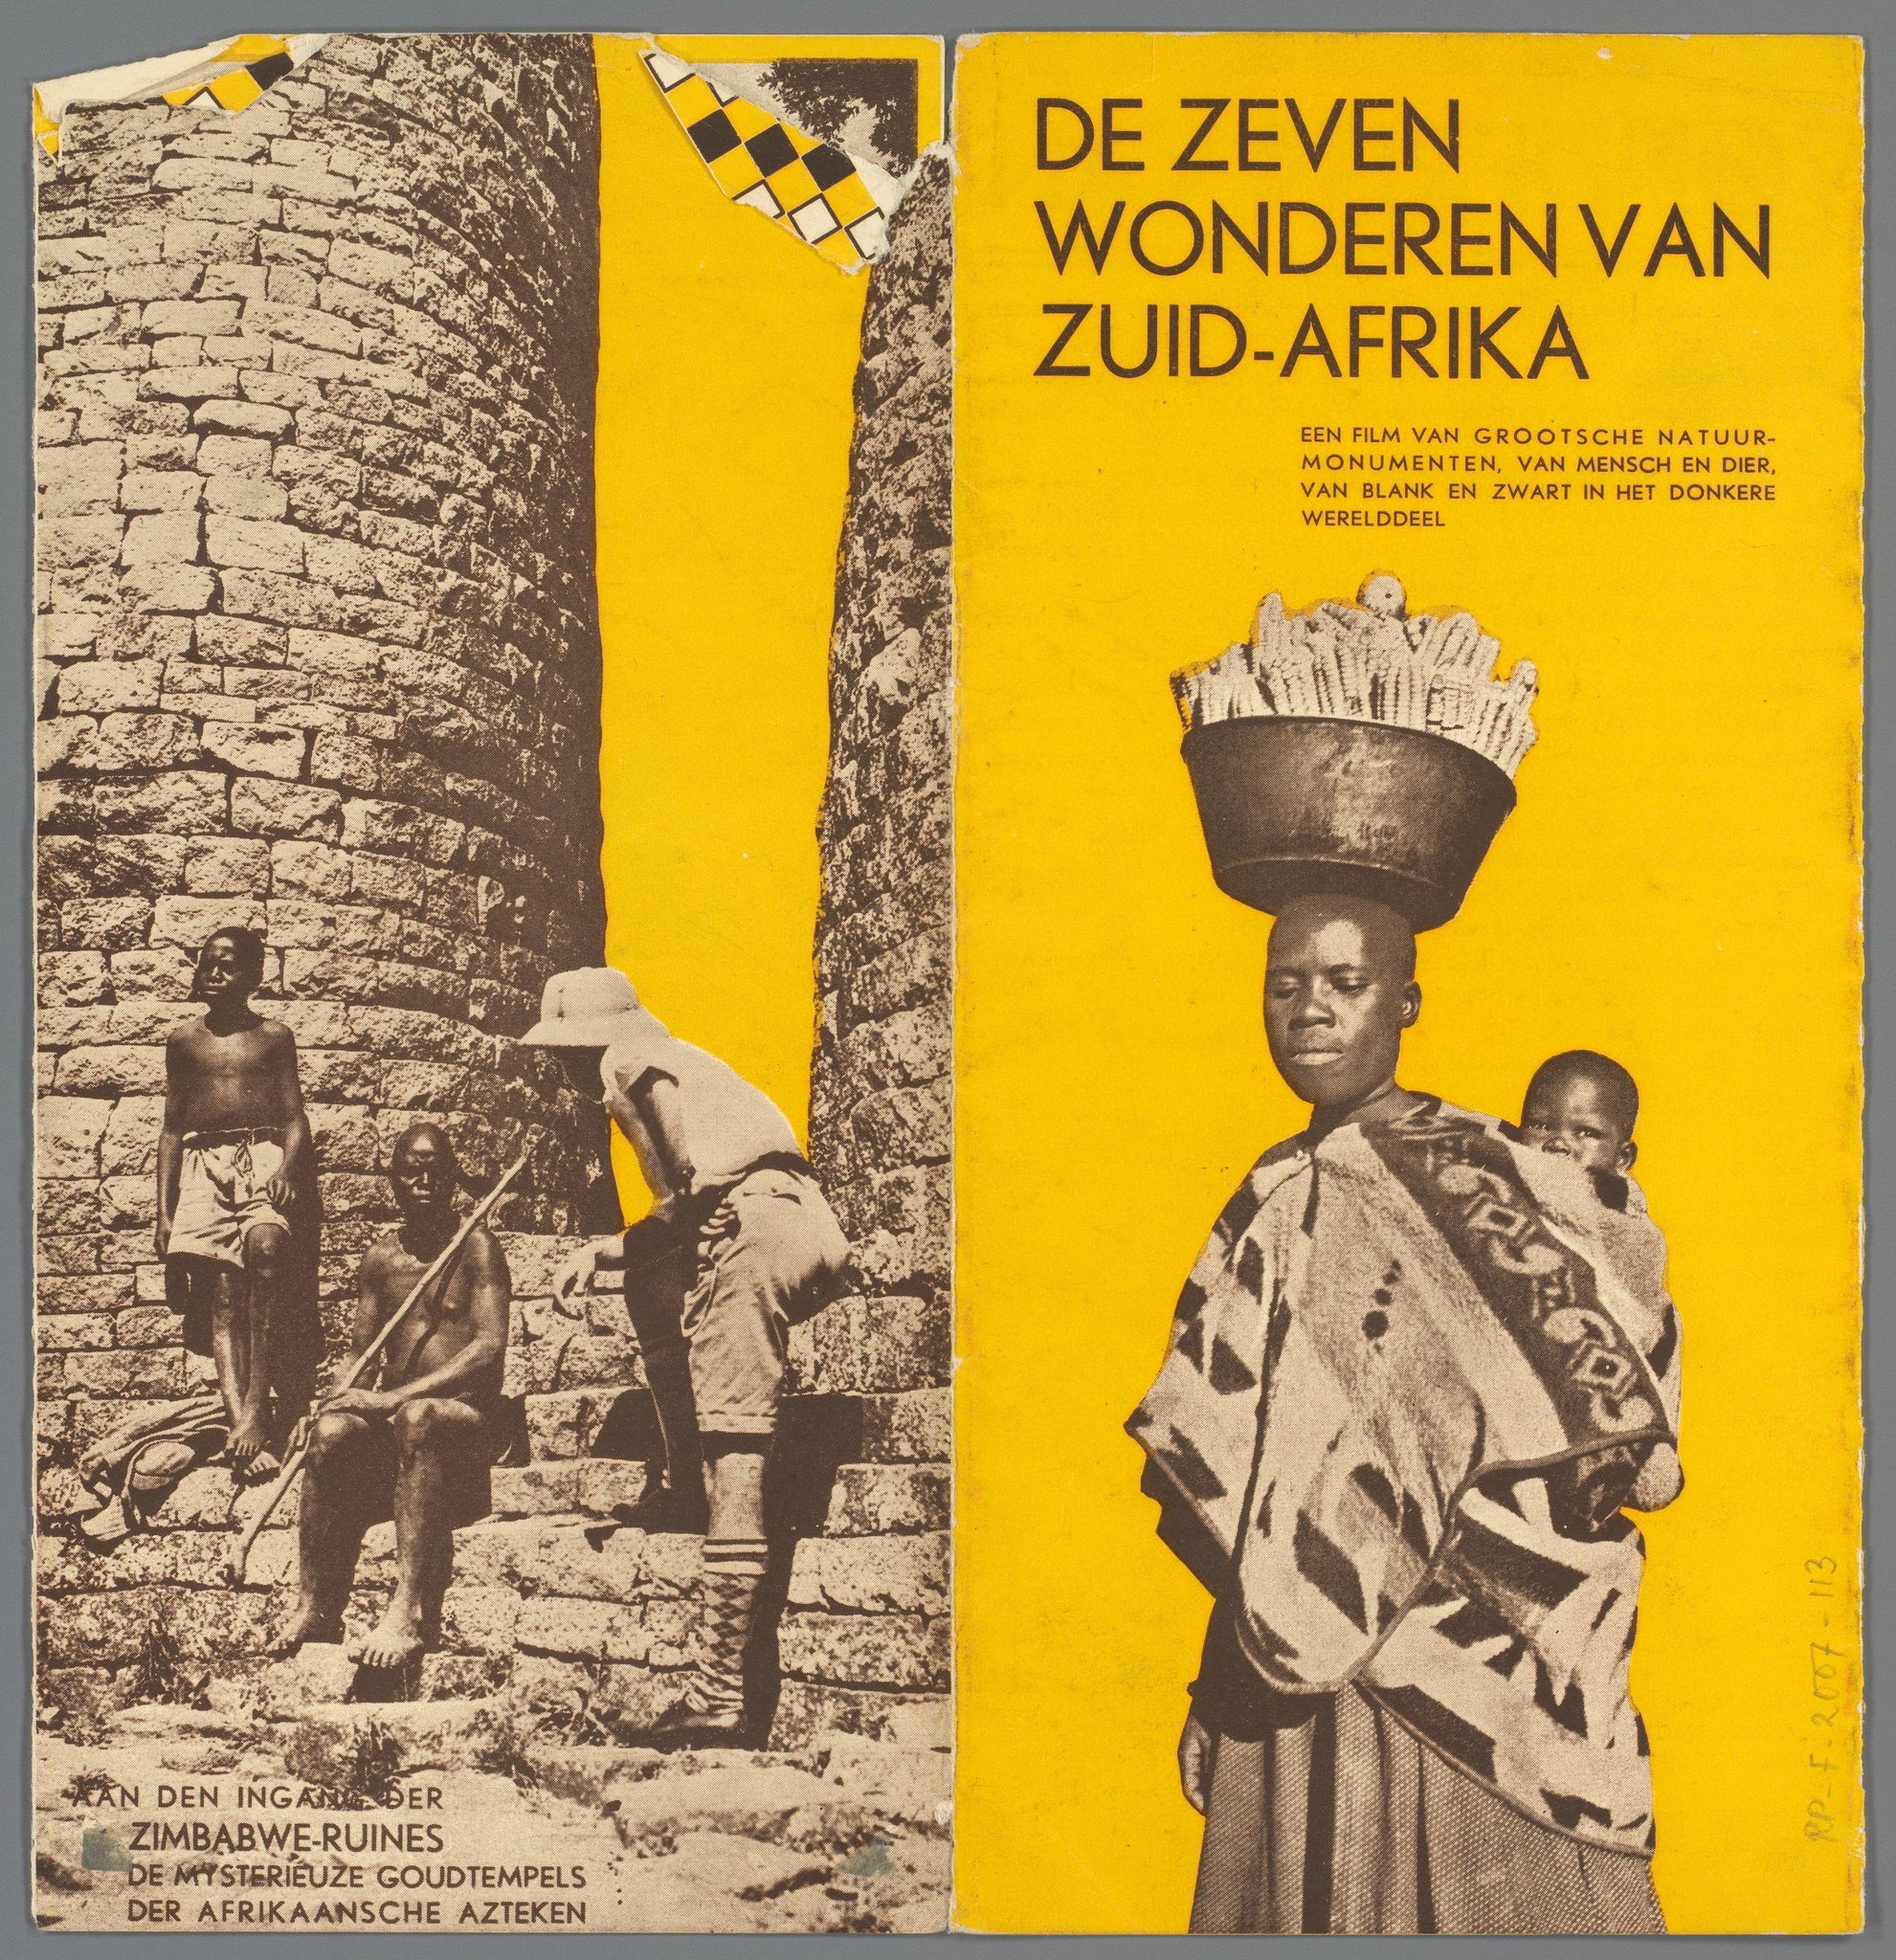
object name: folder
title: Fotomechanisch geïllustreerde folder voor de film 'De zeven wonderen van Zuid-Afrika' door cineast Alphons Hustinx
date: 1934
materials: paper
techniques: autotype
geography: south africa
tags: maastricht, alphons hustinx, 'en route', traveller under way